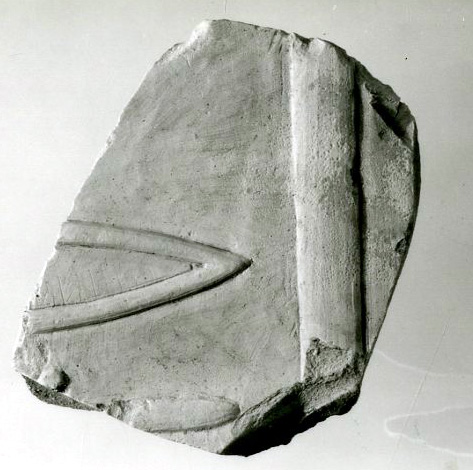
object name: relief fragment, tomb of meketre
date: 1981-1975 BCE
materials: limestone, paint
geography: egypt